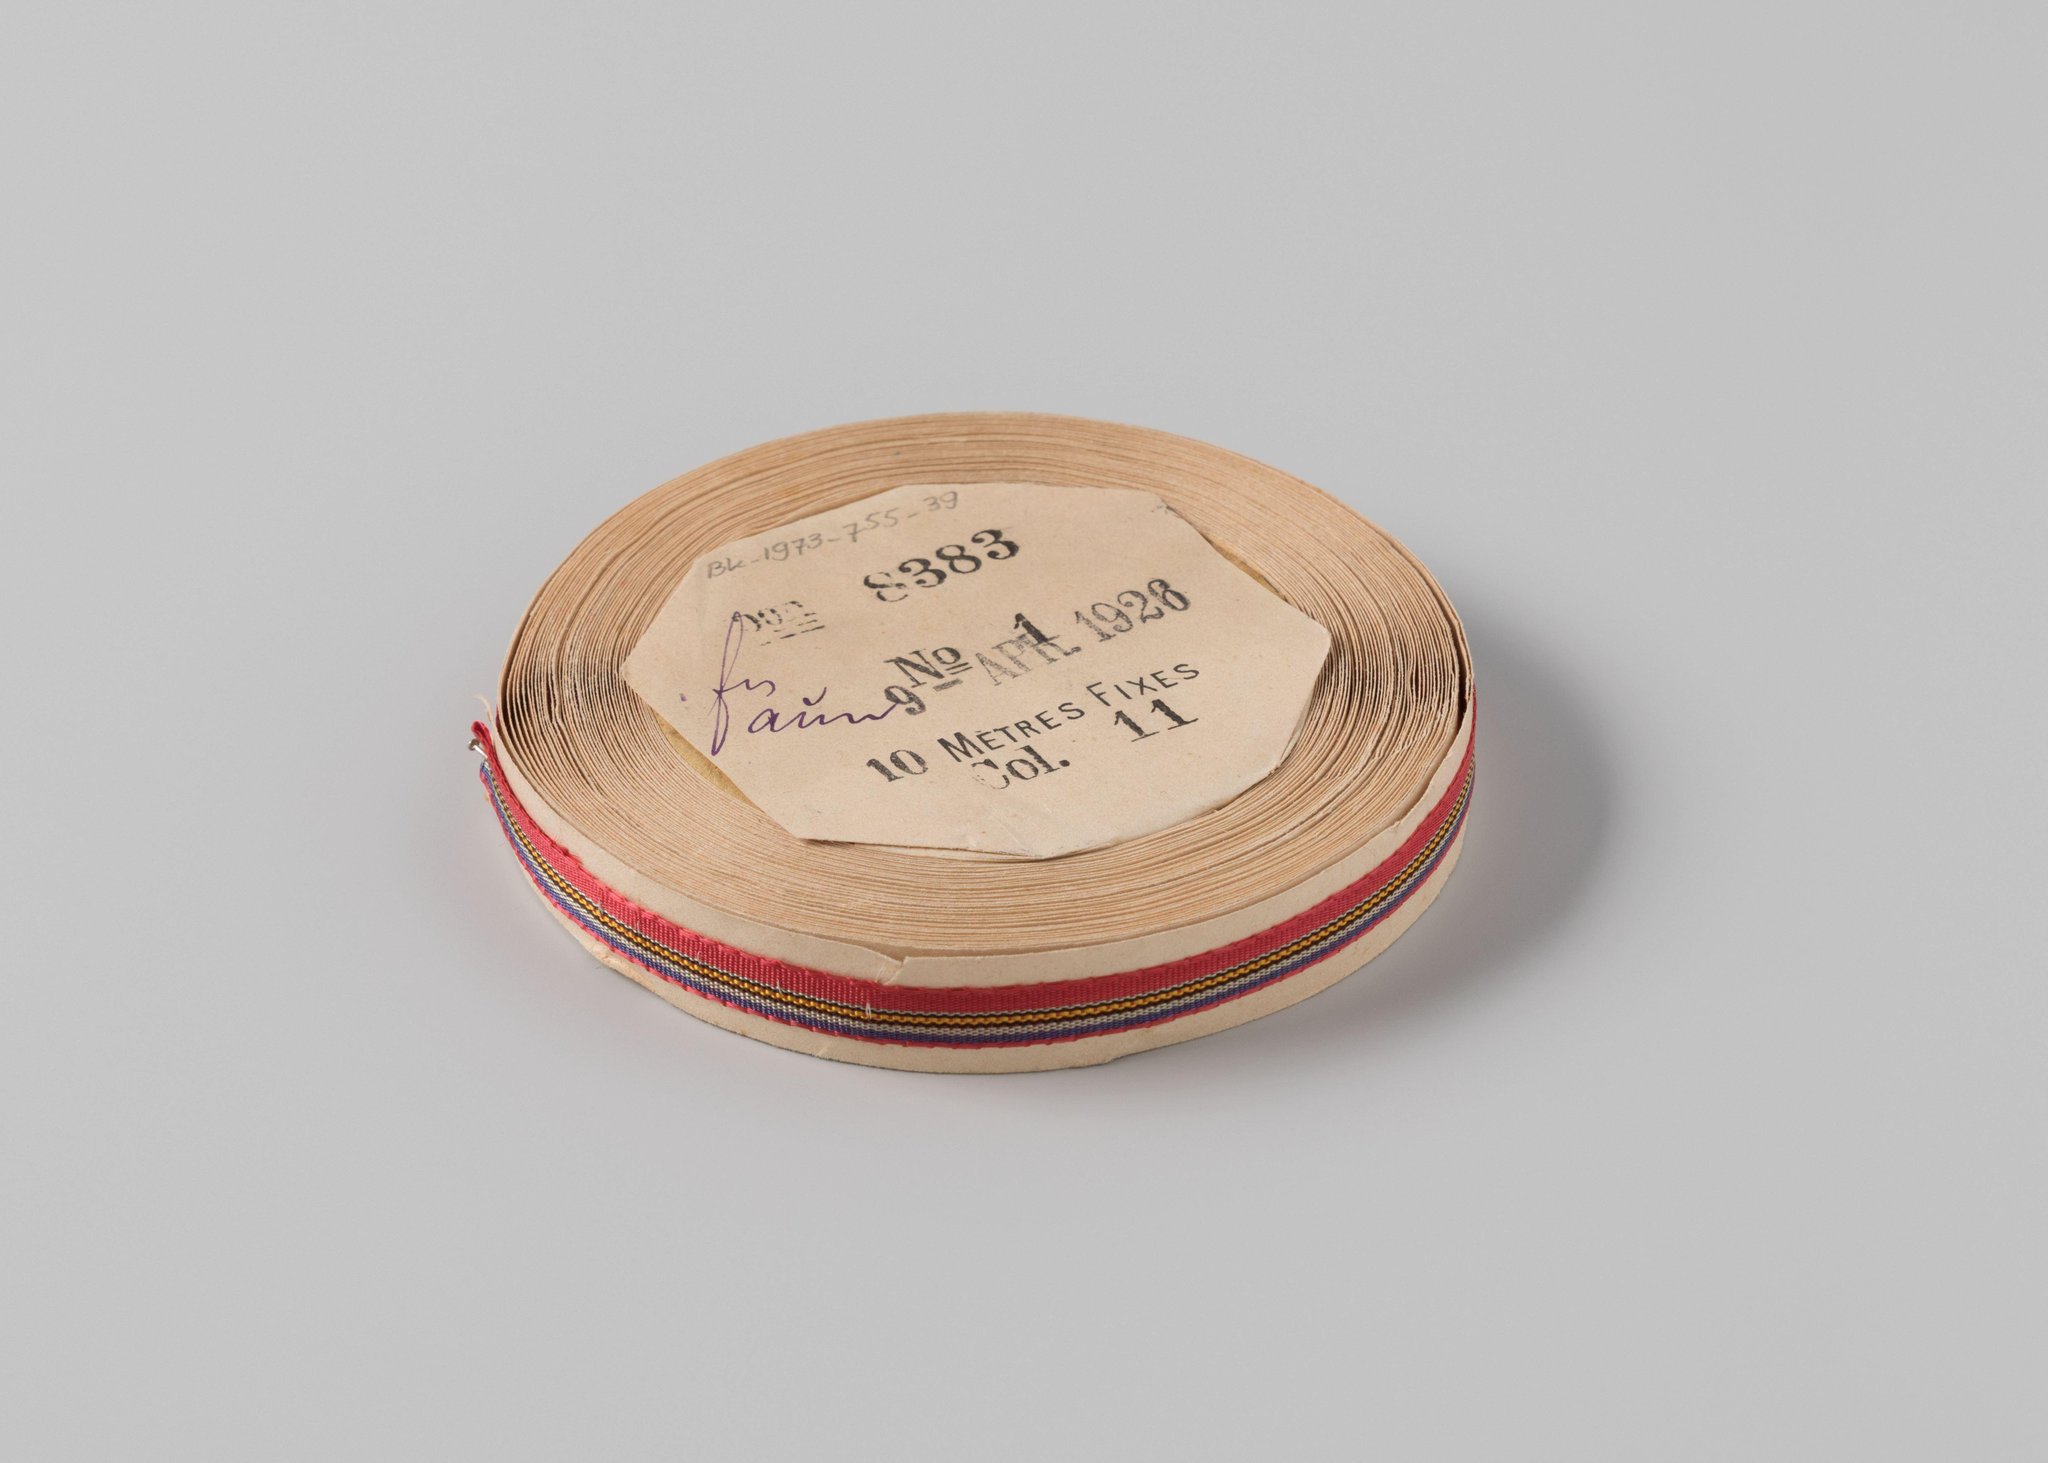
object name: ribbon material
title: Lint op rol, gestreept, rood met beige, zwart, lila en oranje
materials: cardboard, paper, textile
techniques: weave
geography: nijmegen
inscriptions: stamp: ‘9 - APR. 1926’, number: ‘Pon 8383’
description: Lint op rol, gestreept, rood met beige, zwart, lila en oranje.